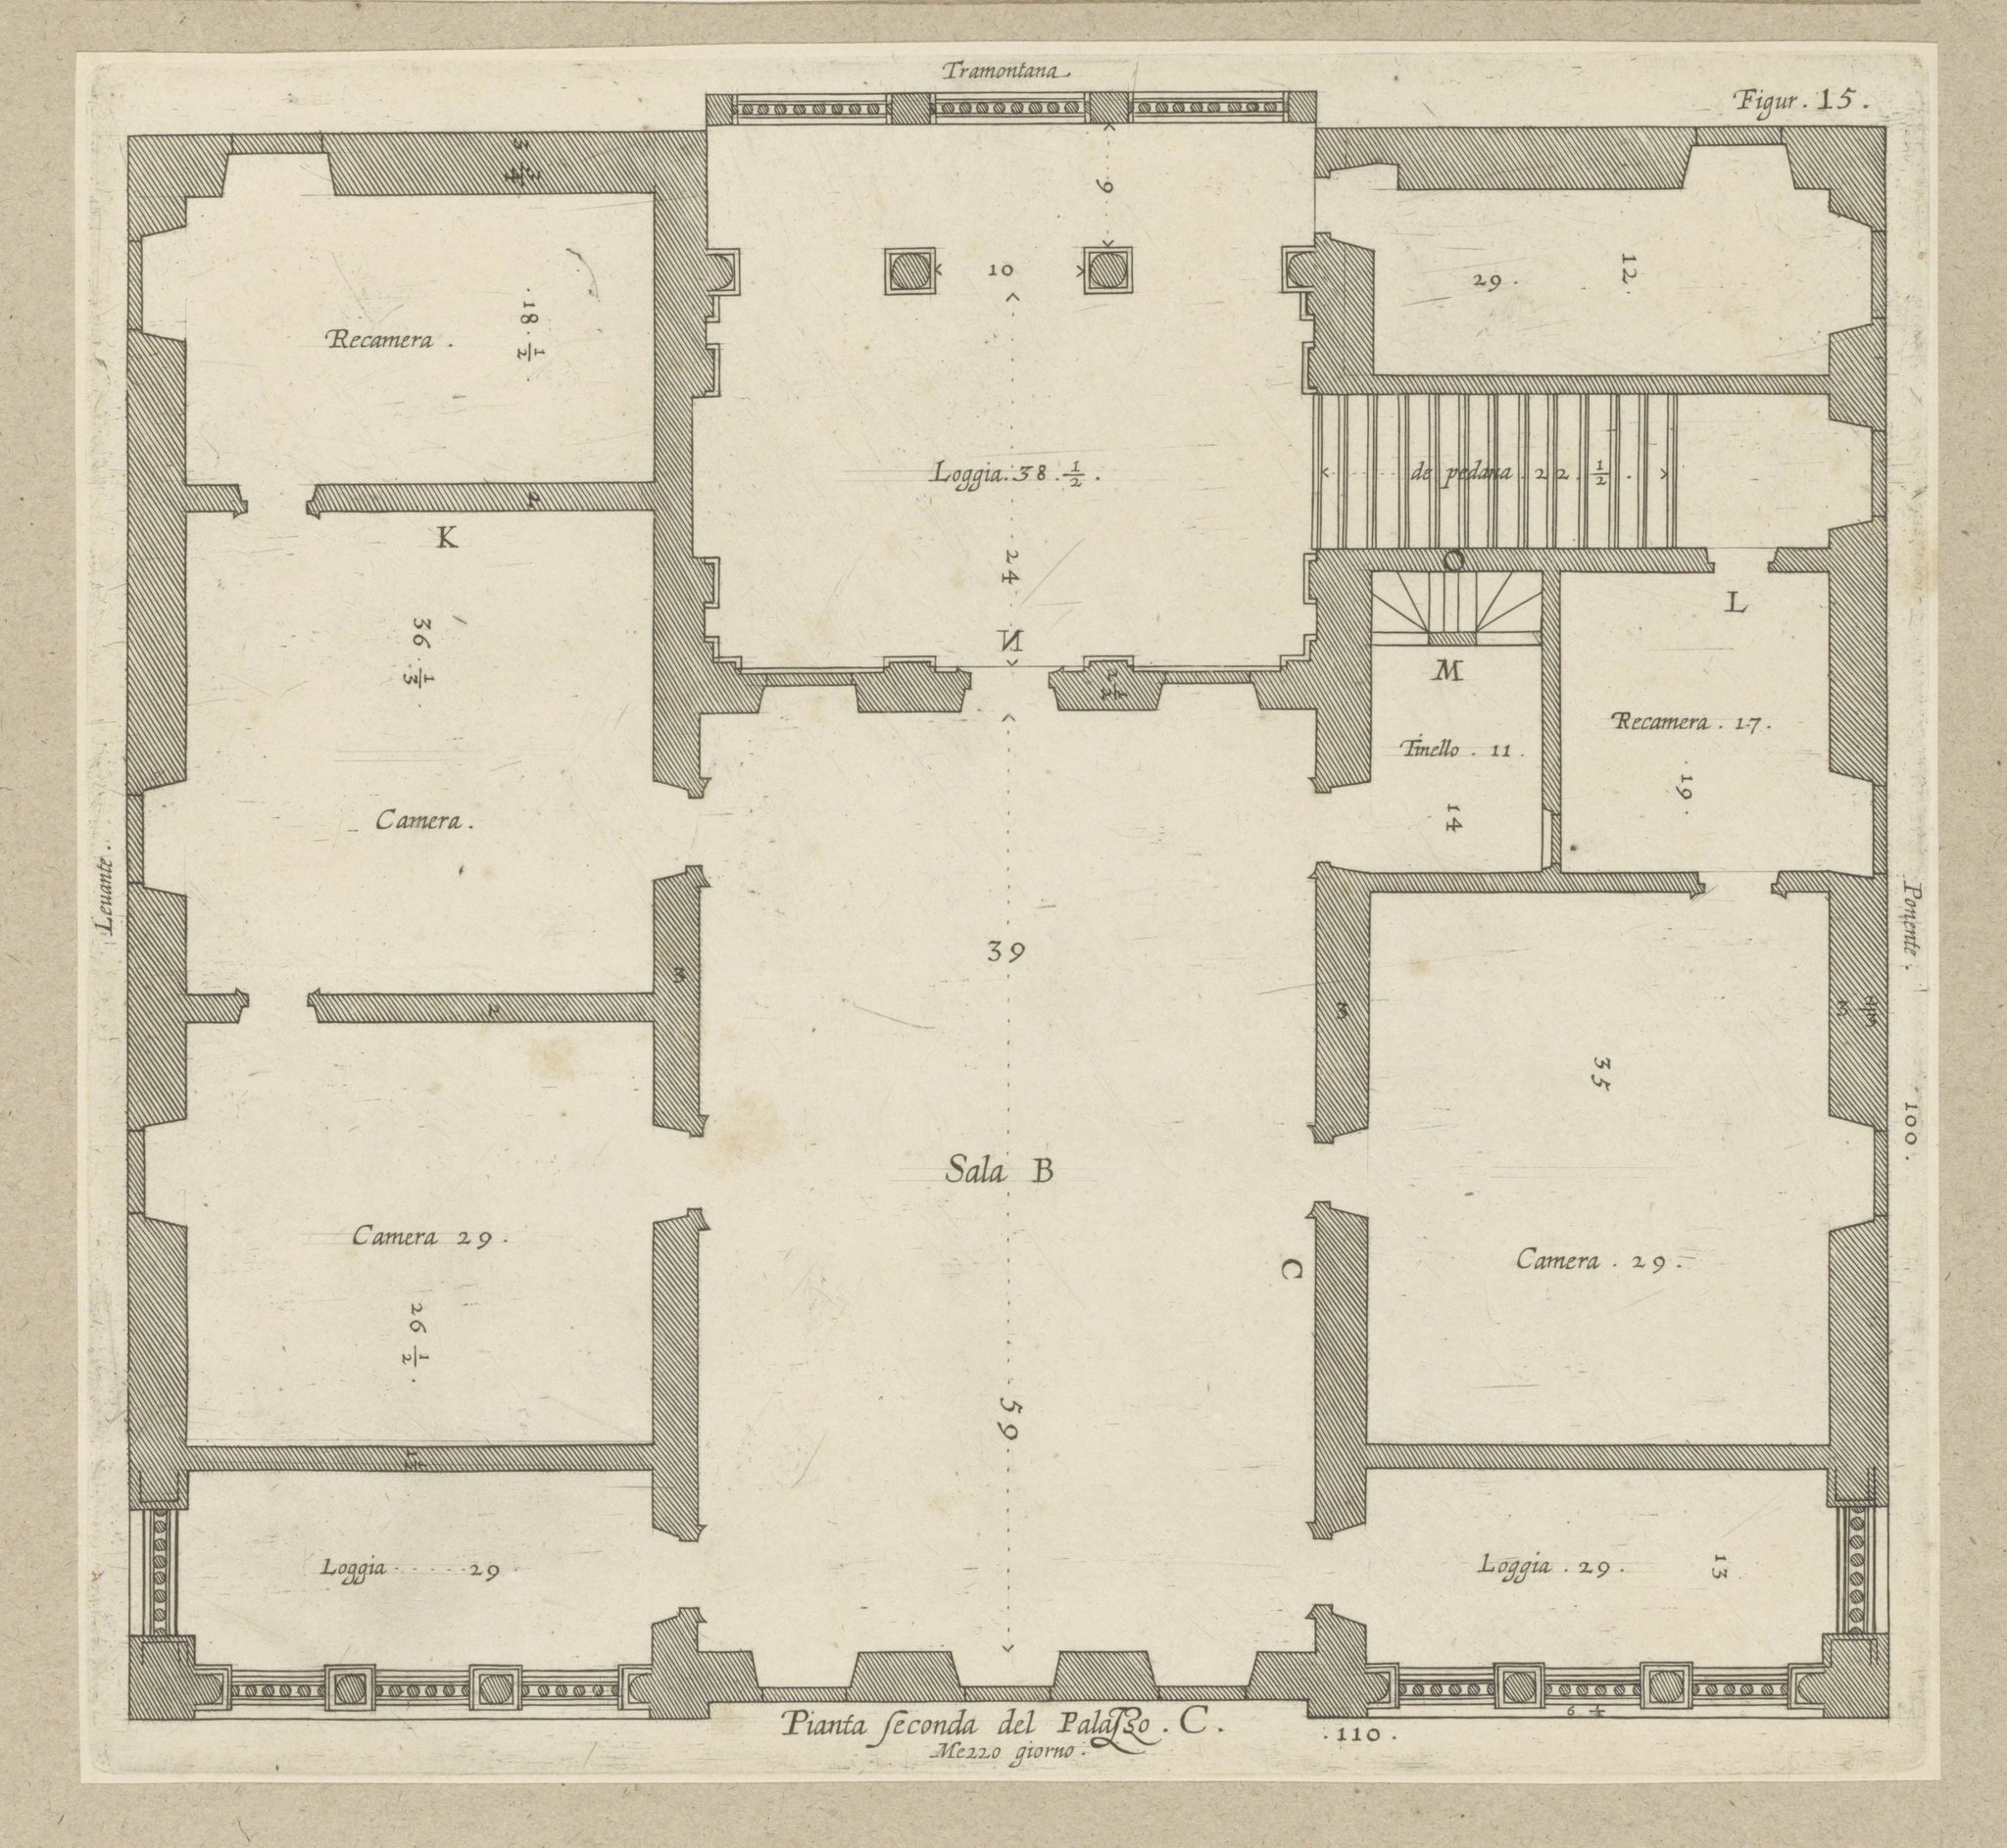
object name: print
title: Pianta seconda del Palazzo. C.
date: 1622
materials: paper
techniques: engraving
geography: antwerp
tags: hôtel, i.e. small palace in city - aa - civic architecture: inside, plan ~ architecture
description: Deze prent maakt deel uit van een album.